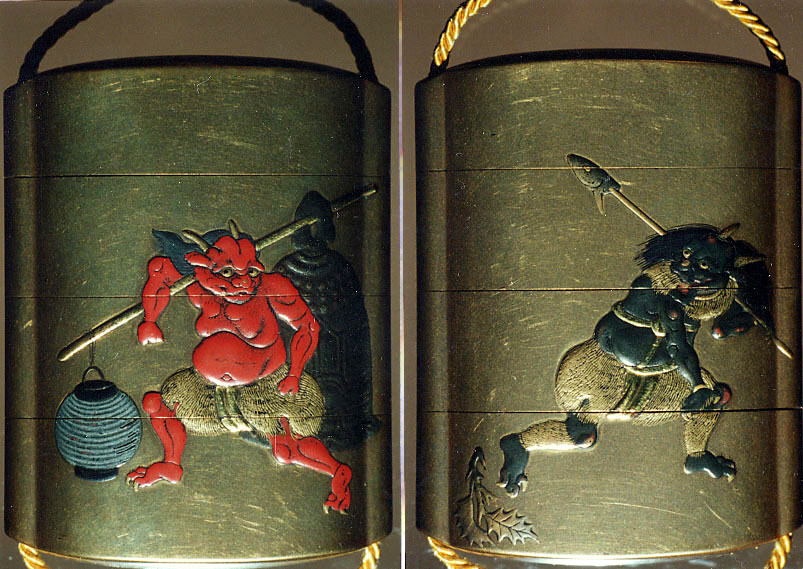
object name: inrō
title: Case (Inrō) with Design of an Oni (Demon) Carrying a Temple Bell and Paper Lantern over His Shoulder (obverse); Oni Carrying Fish Head Stuck on a Pole and Holly Branch (reverse)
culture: japanese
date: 1701-1900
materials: gold, lacquer, silver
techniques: fundame, hiramakie, maki-e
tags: musical instruments,fish,demons